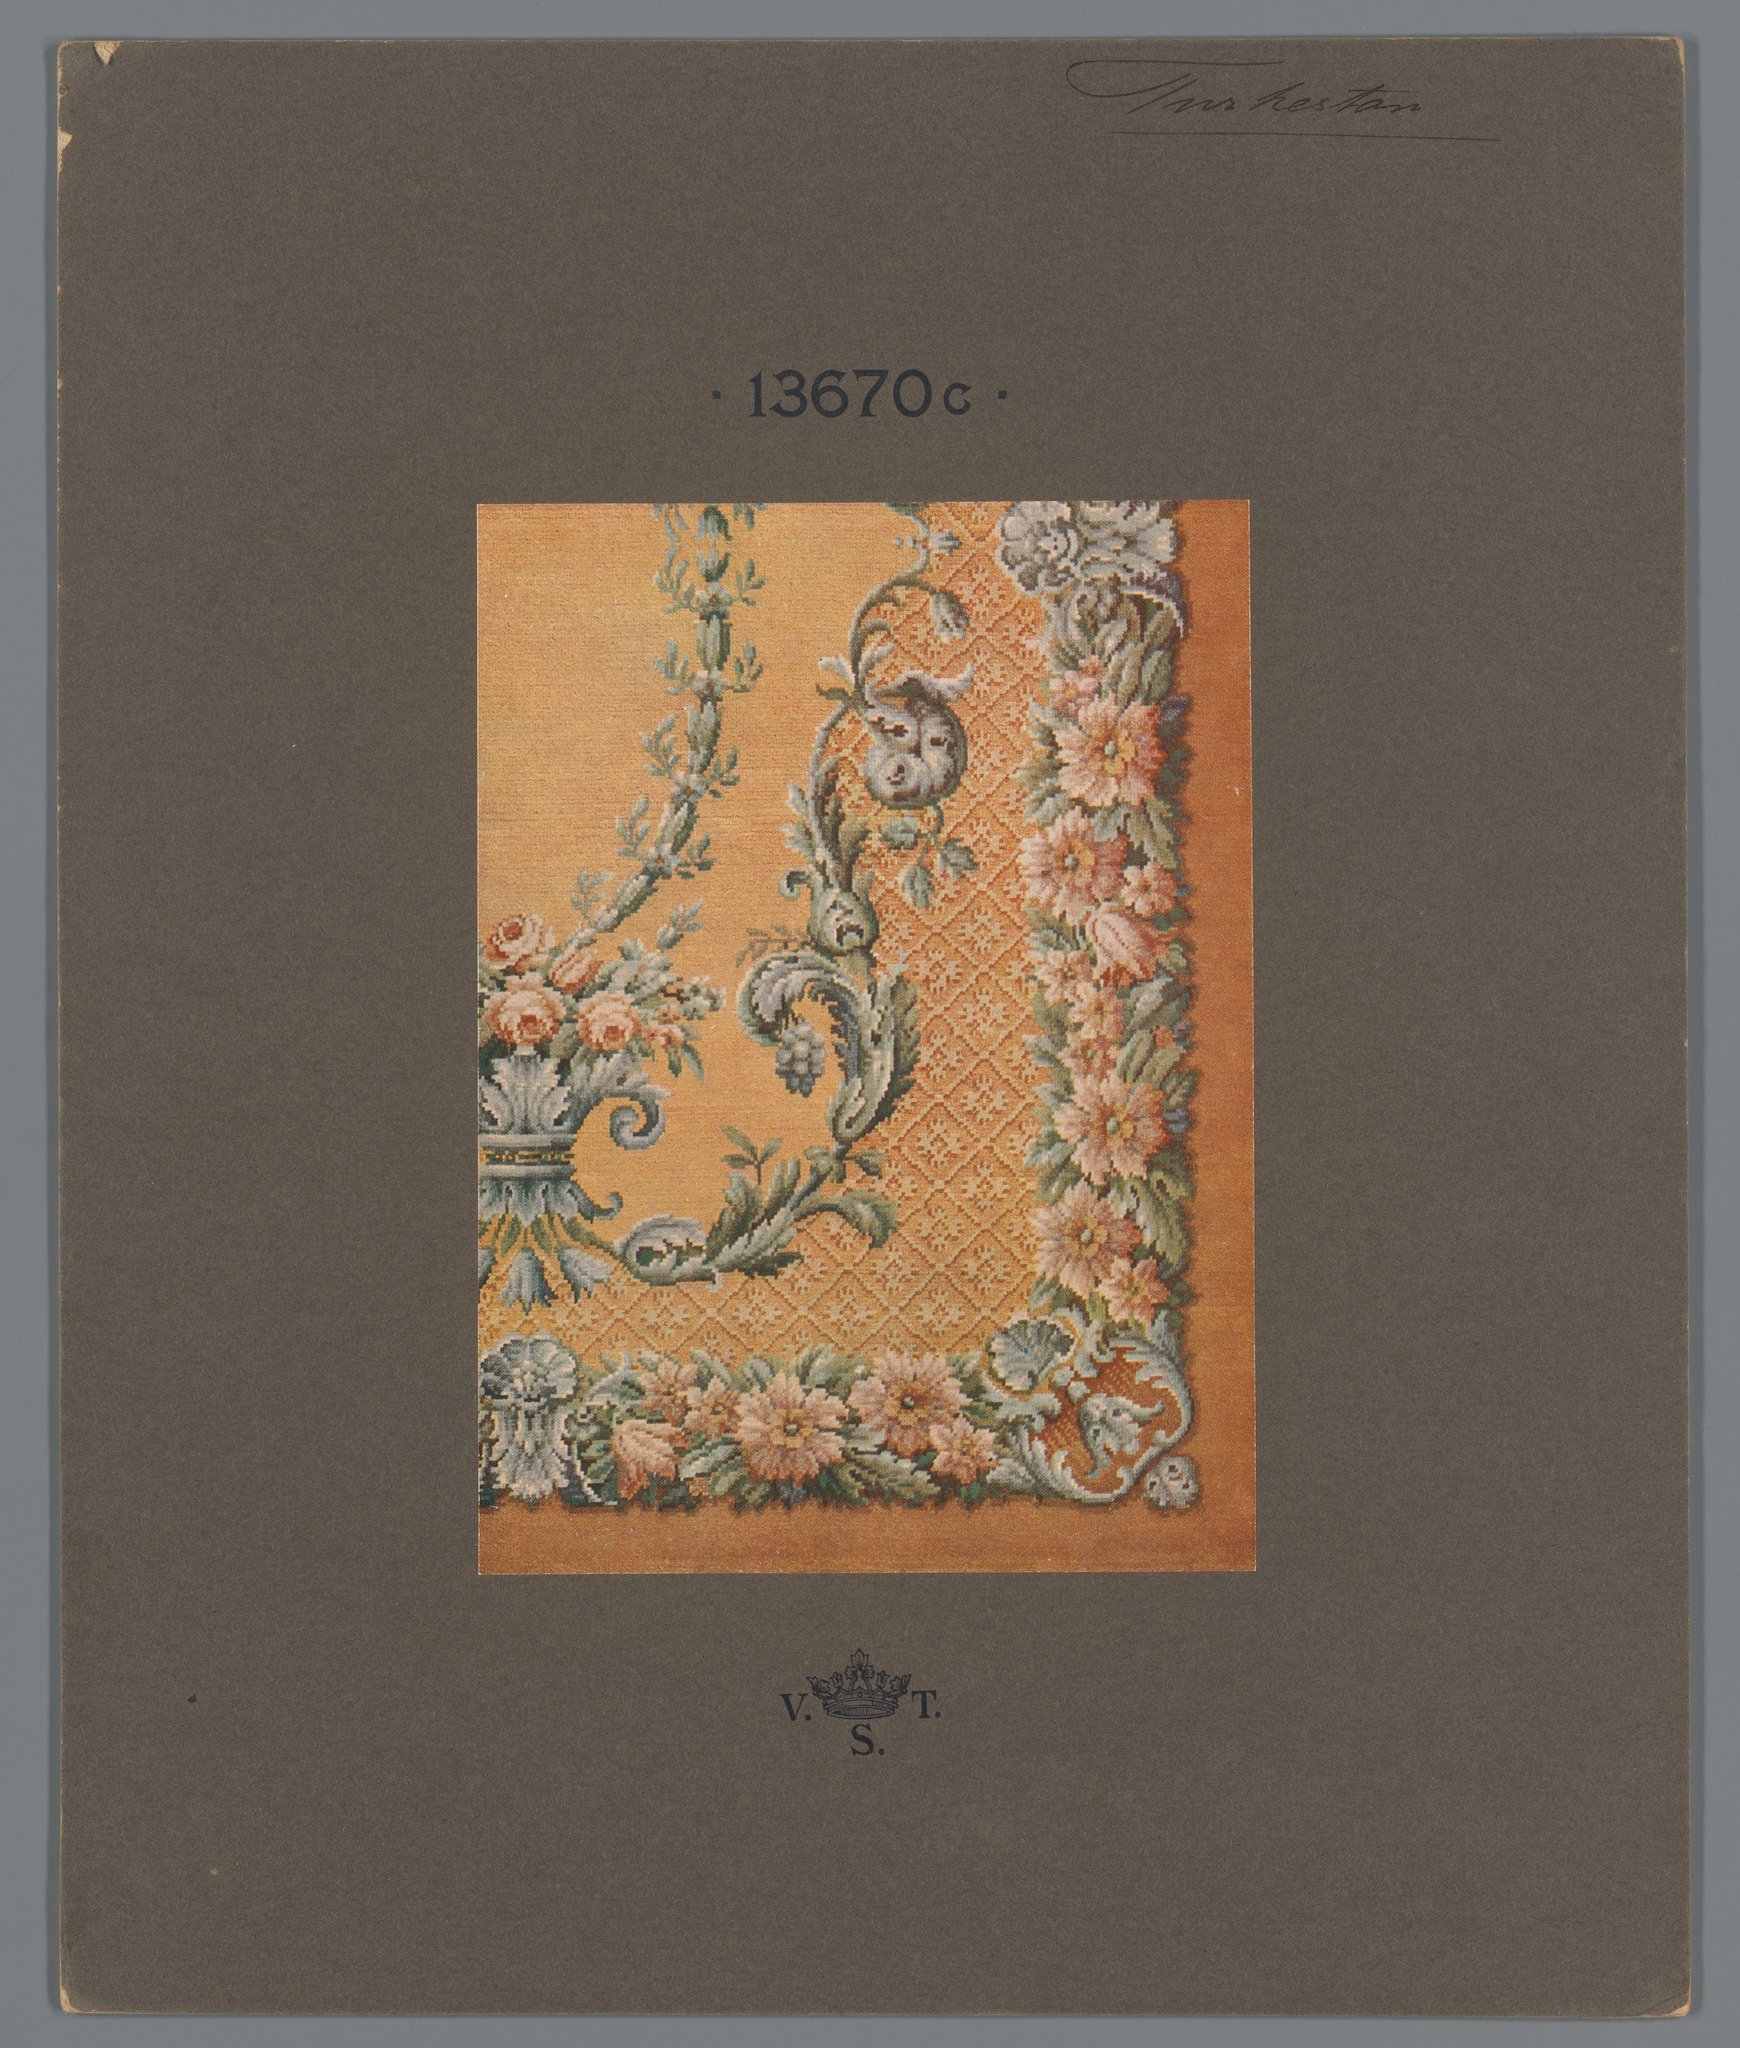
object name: photomechanical print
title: Deel van een tapijt met bloemen- en bladpatroon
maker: Anonymous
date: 1907-1929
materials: cardboard, paper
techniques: autotype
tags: fantasy ornament, carpet, rug, foliage, tendrils, branches ~ ornament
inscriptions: number: ‘.13670c.’, annotation: ‘Turkestan’, mark: ‘V.T.S.’, annotation: ‘Turkestan’